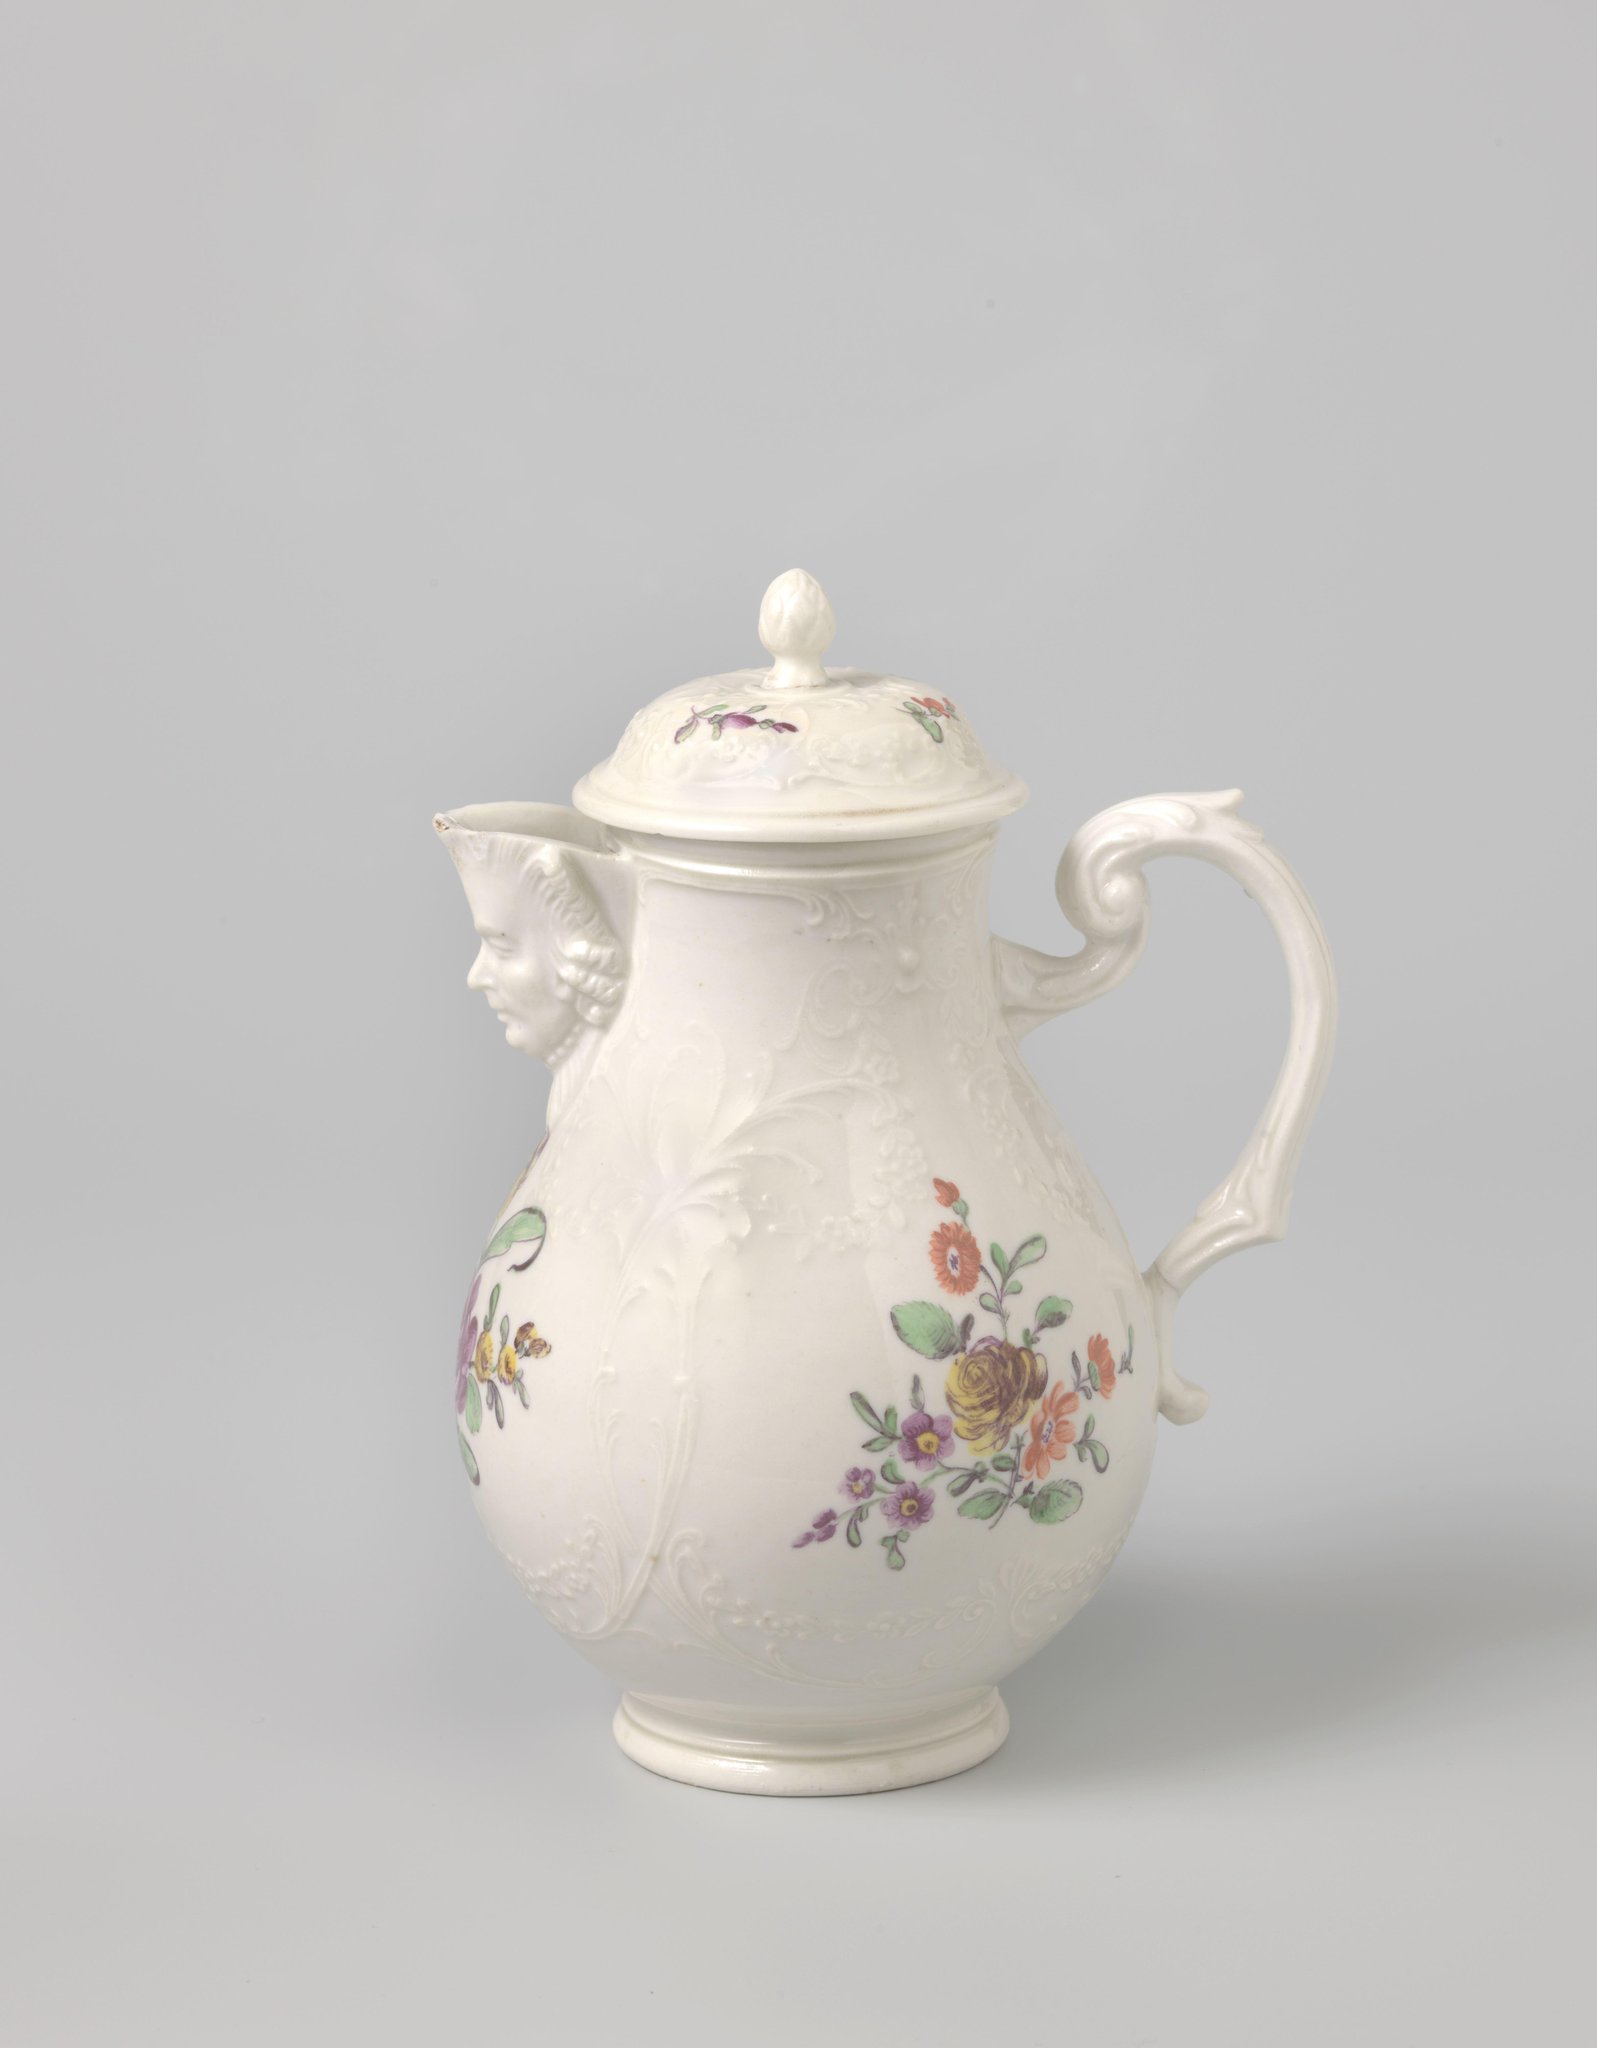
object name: lid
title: Cover of a ewer with flowers and floral scrolls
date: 1775-1780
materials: glaze, paint, porcelain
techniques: firing, forming, turning, vitrification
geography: würzburg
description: Deksel van een kan van porselein met rocaille oor en driehoekige tuit vanuit de nek, beschilderd op het glazuur in rood, groen, geel en zwart. Versierd met bloemranken in licht reliëf met daarop geschilderde bloemen. Dekselknop in de vorm van een dennenappel.